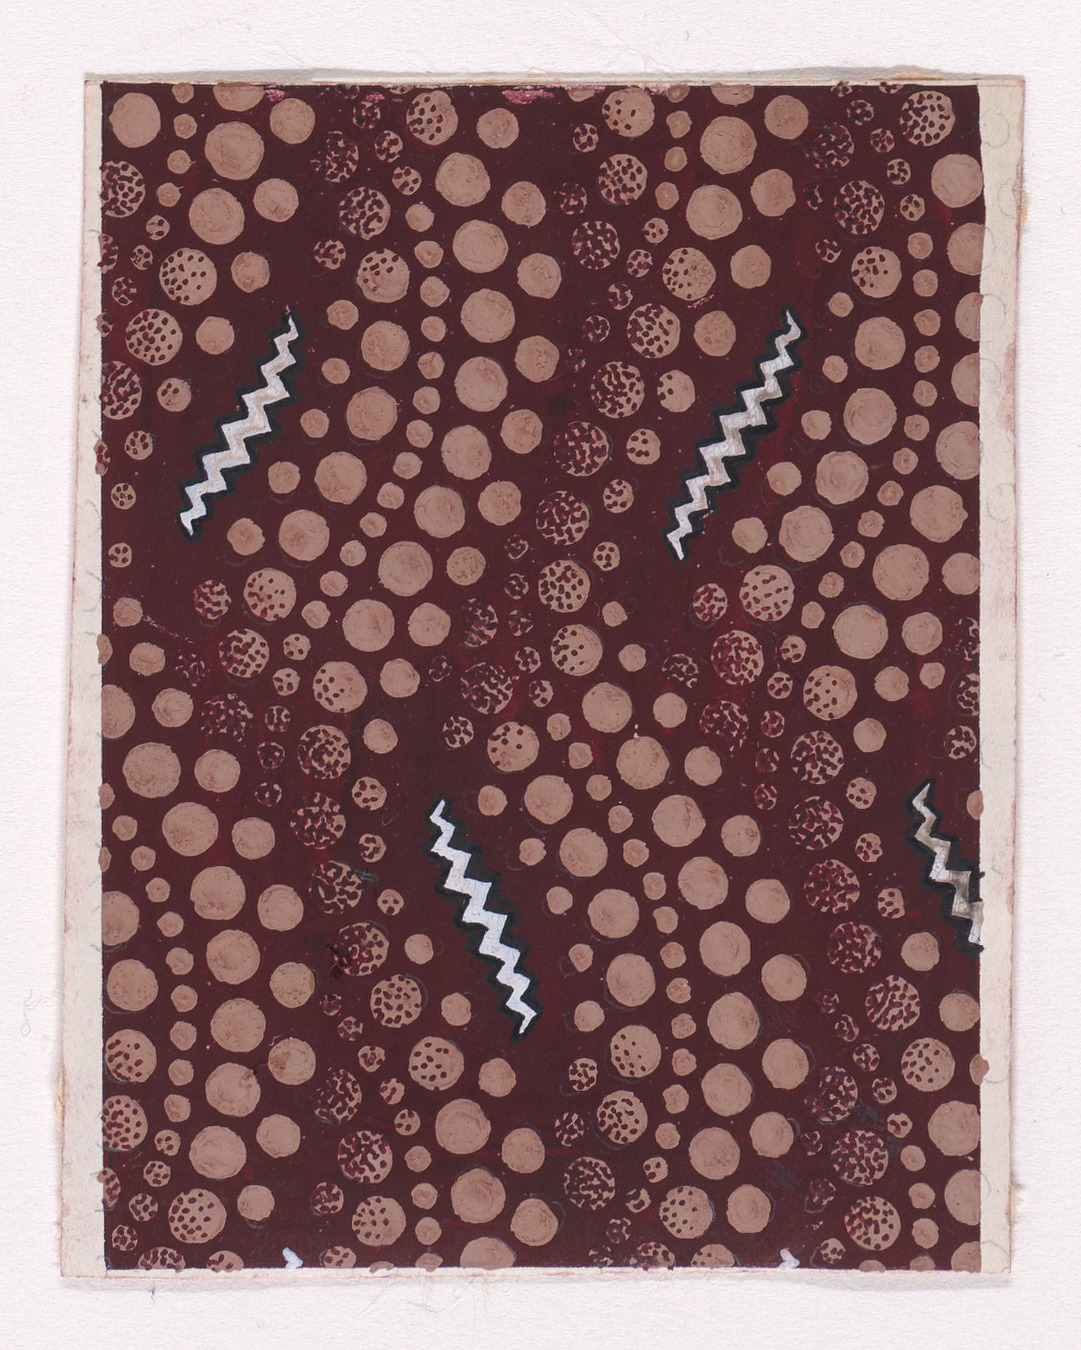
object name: drawing ornament architecture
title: Textile Design with Overlapping Verical Strips of Undulating Rows of Dots and Zig-Zagging Ribbons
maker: anonymous, alsatian, 19th century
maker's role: artist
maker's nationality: alsatian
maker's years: 1800-1900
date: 1840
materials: gouache